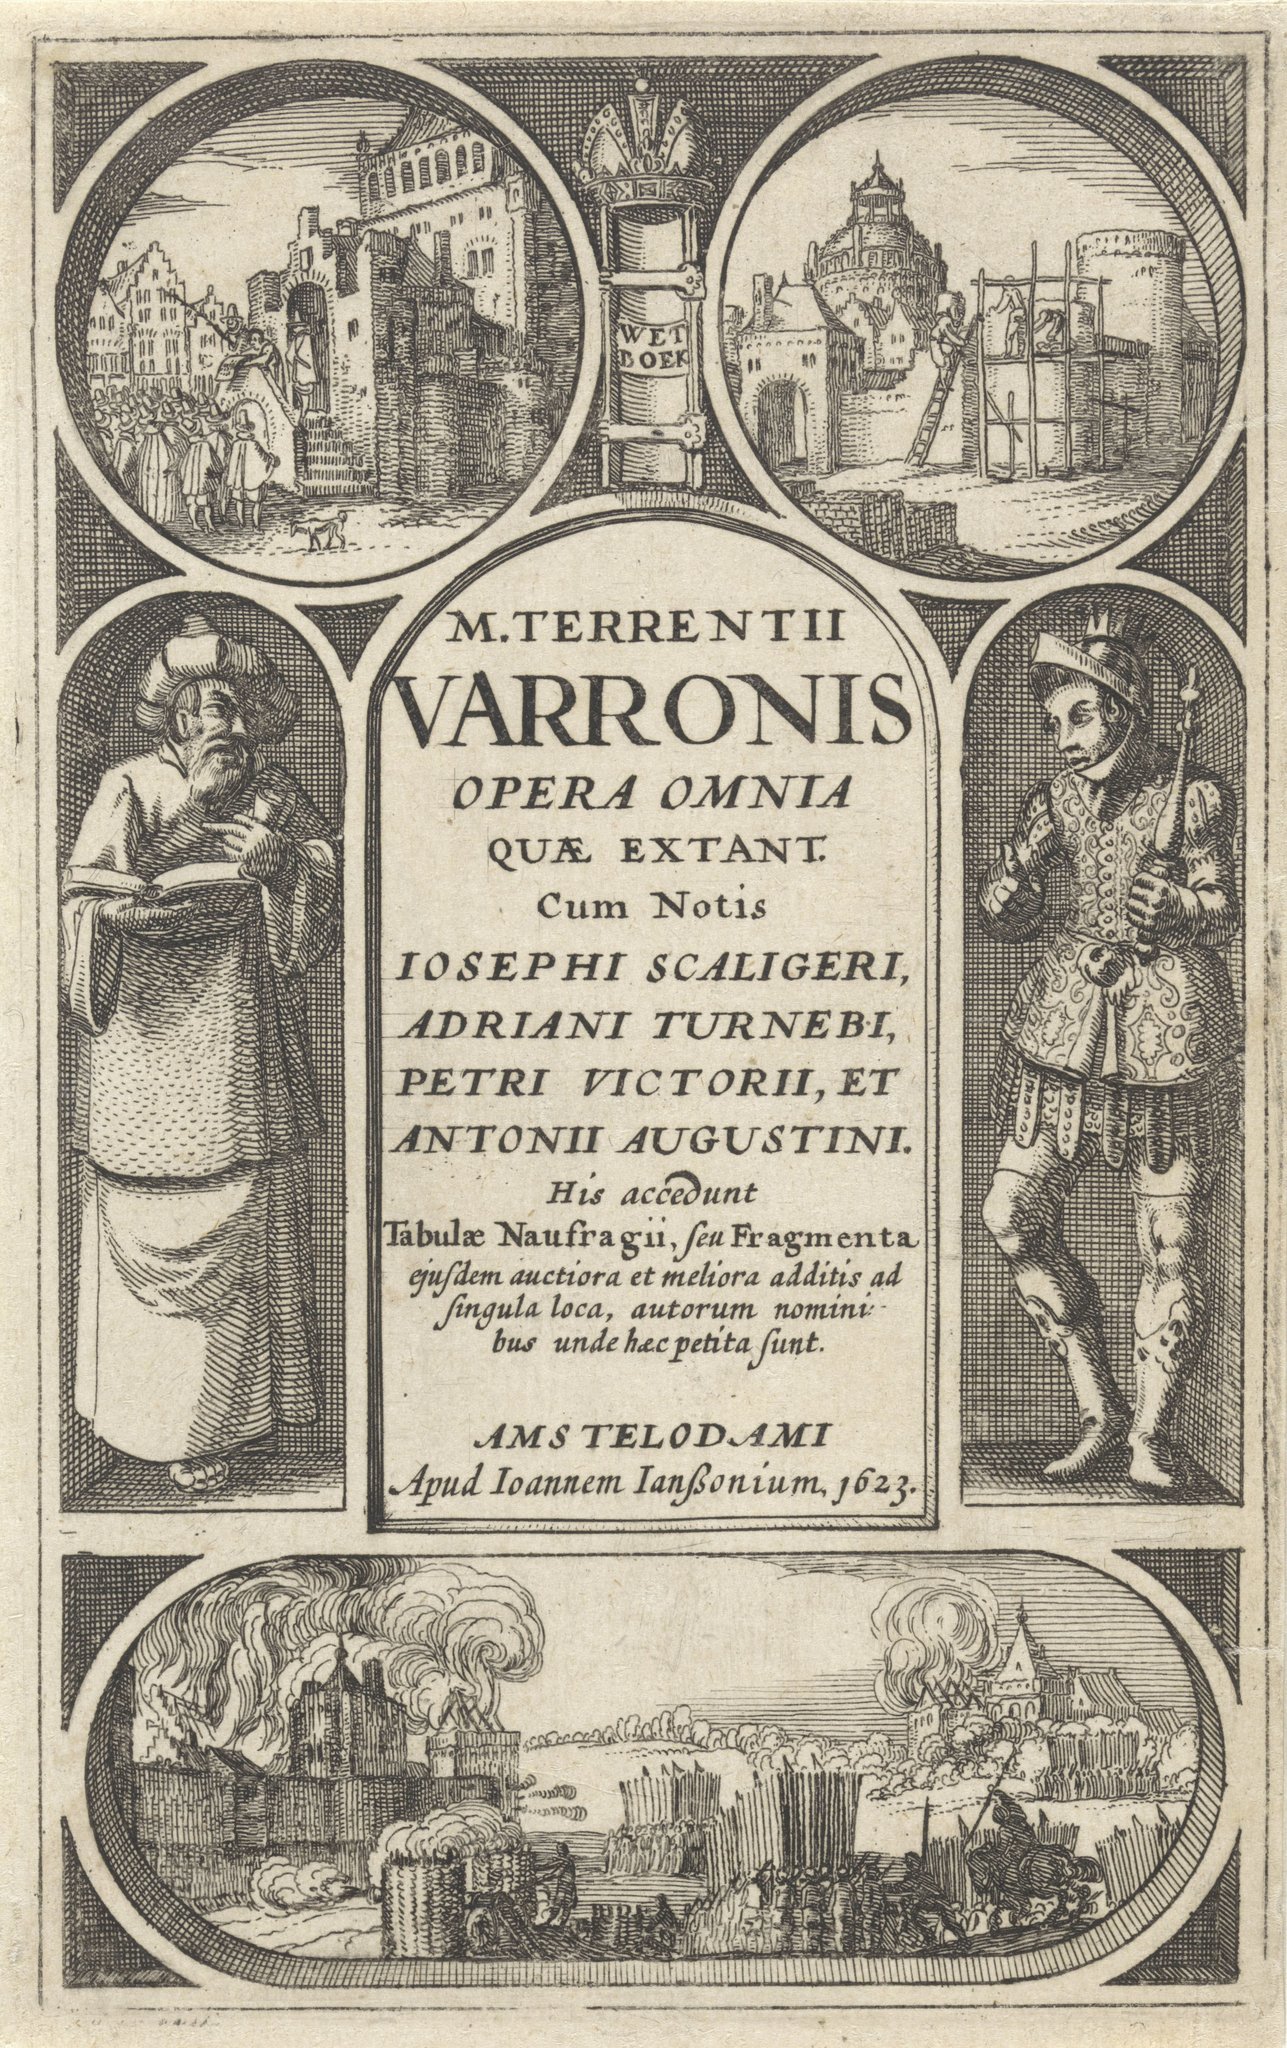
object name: titelblad, titelpagina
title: Titelpagina voor: Opera omnia qvæ extant, 1623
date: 1623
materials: paper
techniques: etching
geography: amsterdam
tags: city-view, and landscape with man-made constructions, crown (symbol of sovereignty), armour, attack ~ siege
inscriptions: title: ‘M. TERRENTII VARRONIS OPERA OMNIA....sunt’ boektitel, collector's mark: Lugt 2228, address and date: ‘Amstelodami / Apud Ioannem Ianssonium, 1623’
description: Titelpagina met in het midden een boogvormig kader waarin de titel van het boek, geflankeerd door een geleerde en een ridder. Boven de titel twee cirkelvormige vensters met links een menigte die wordt toegesproken vanaf de trap van een stadhuis, en rechts de bouw van een fort. Tussen de twee bovenste vensters een gekroond wetboek. Onder de titel een ovaal venster waarin een beleging van een stad te zien is.